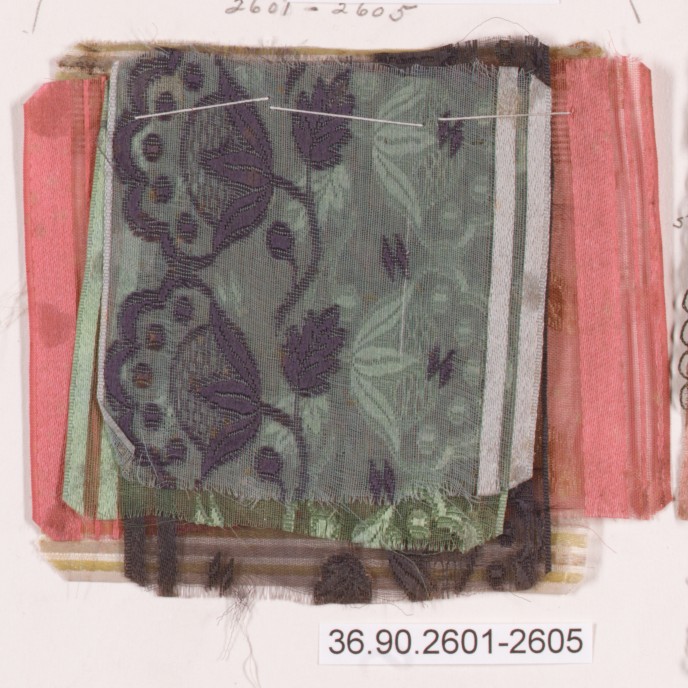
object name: ribbon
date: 1801-1900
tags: flowers